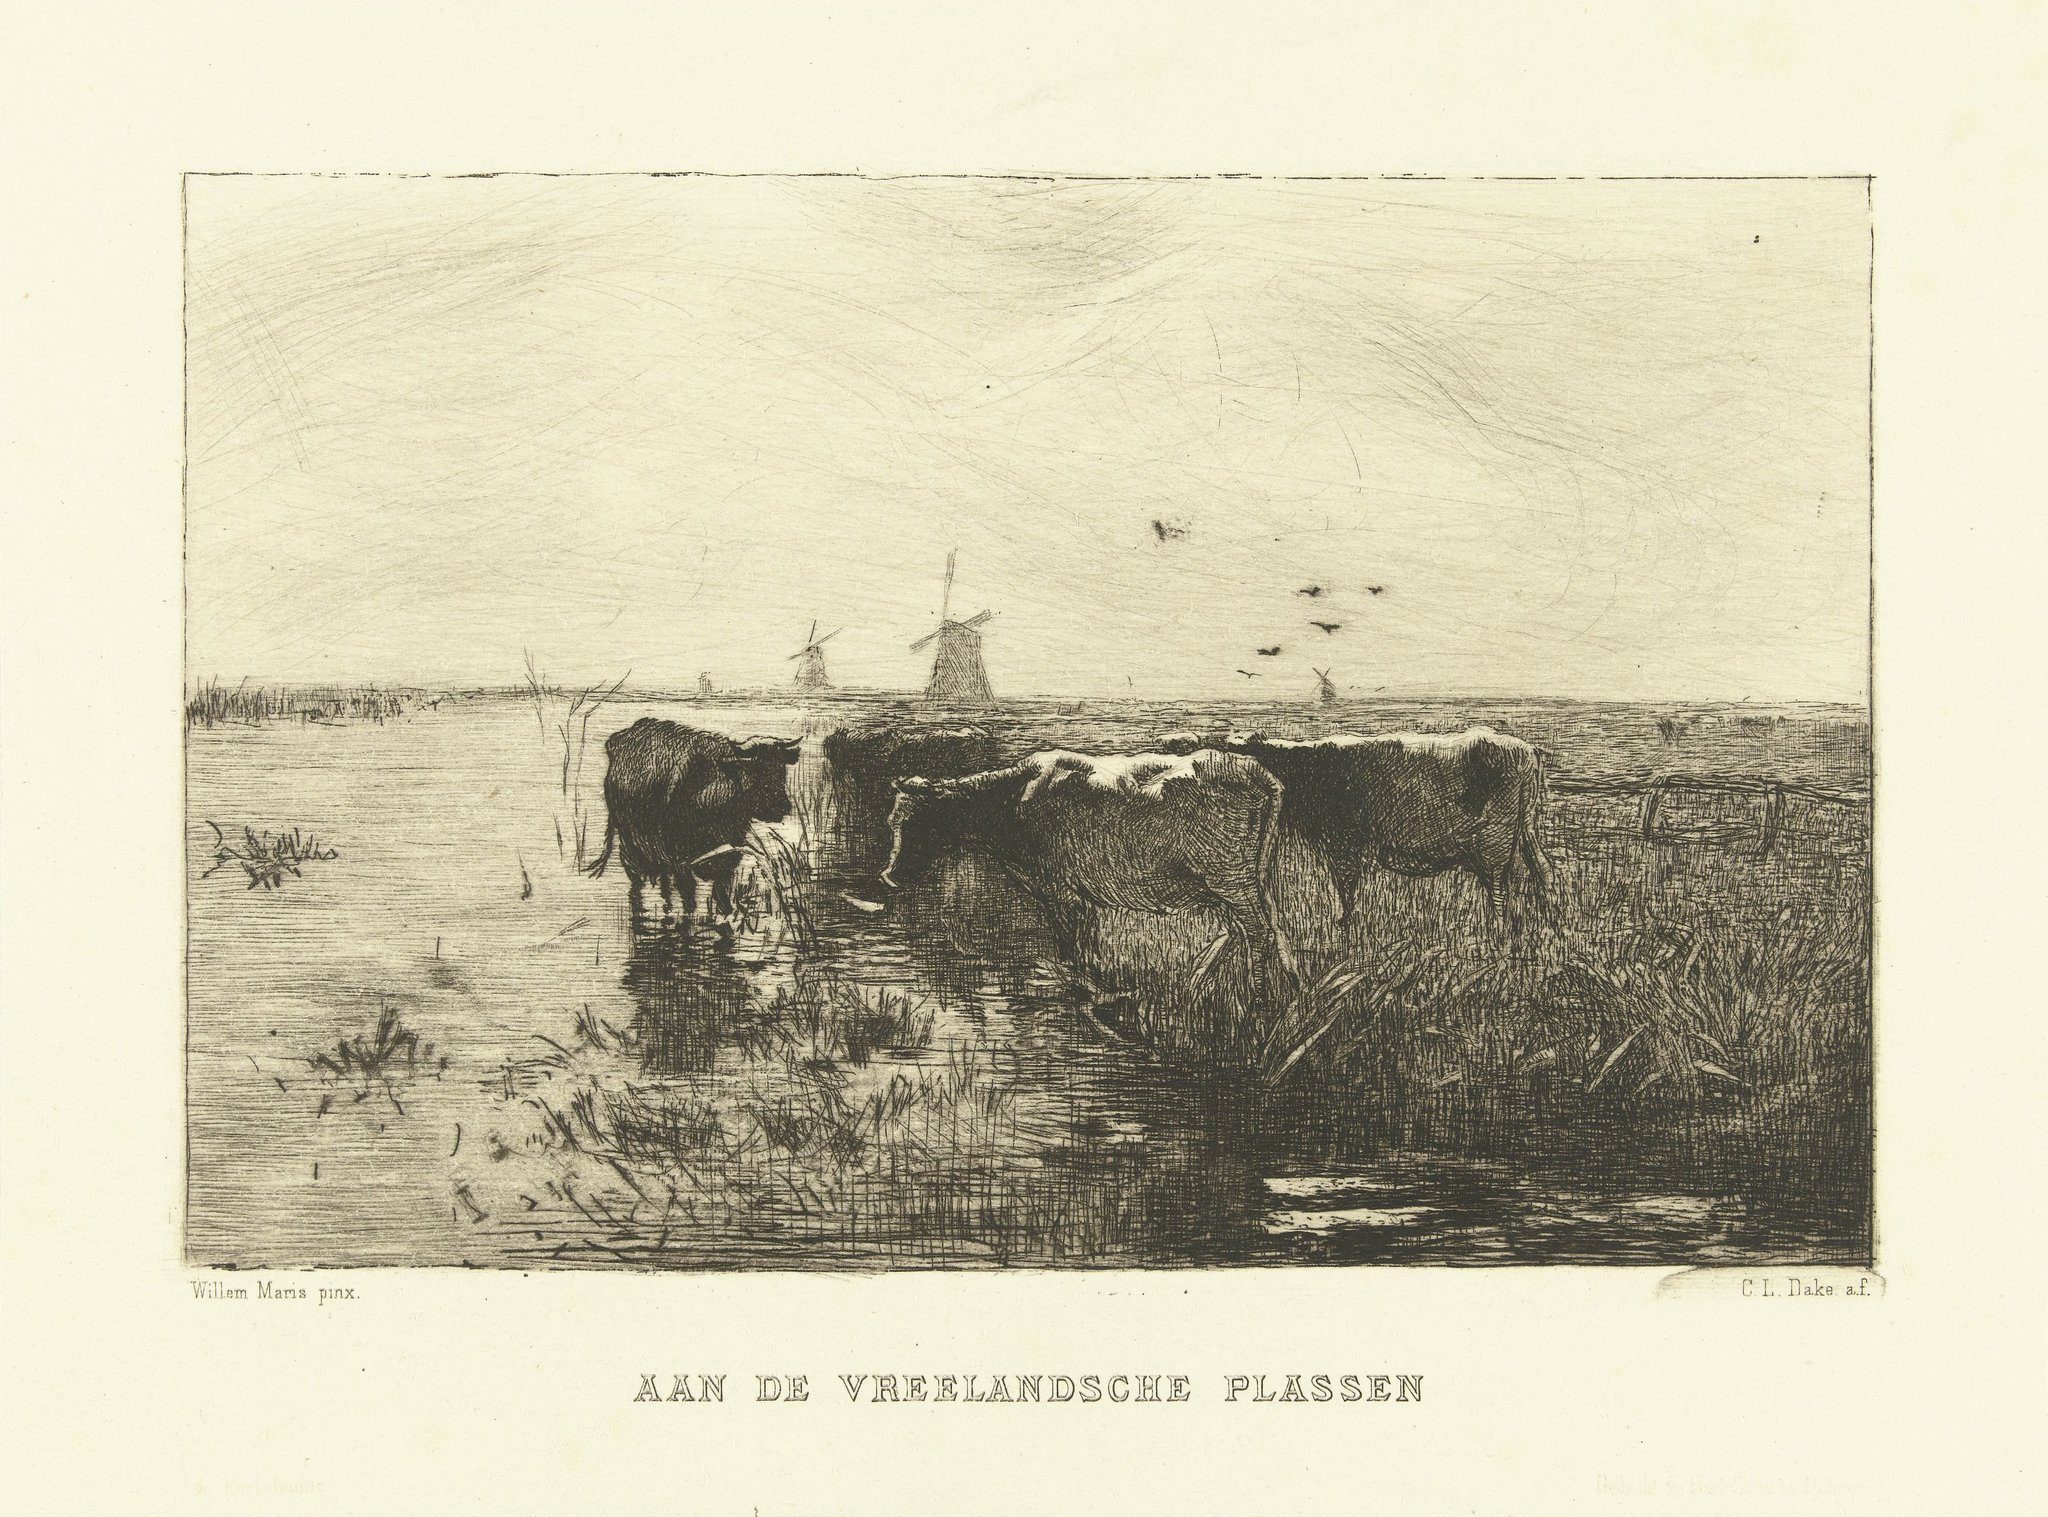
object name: print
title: Aan de Vreelandsche plassen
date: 1867-1918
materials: paper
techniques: drypoint, etching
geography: netherlands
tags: windmill in landscape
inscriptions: collector's mark: Lugt 2228